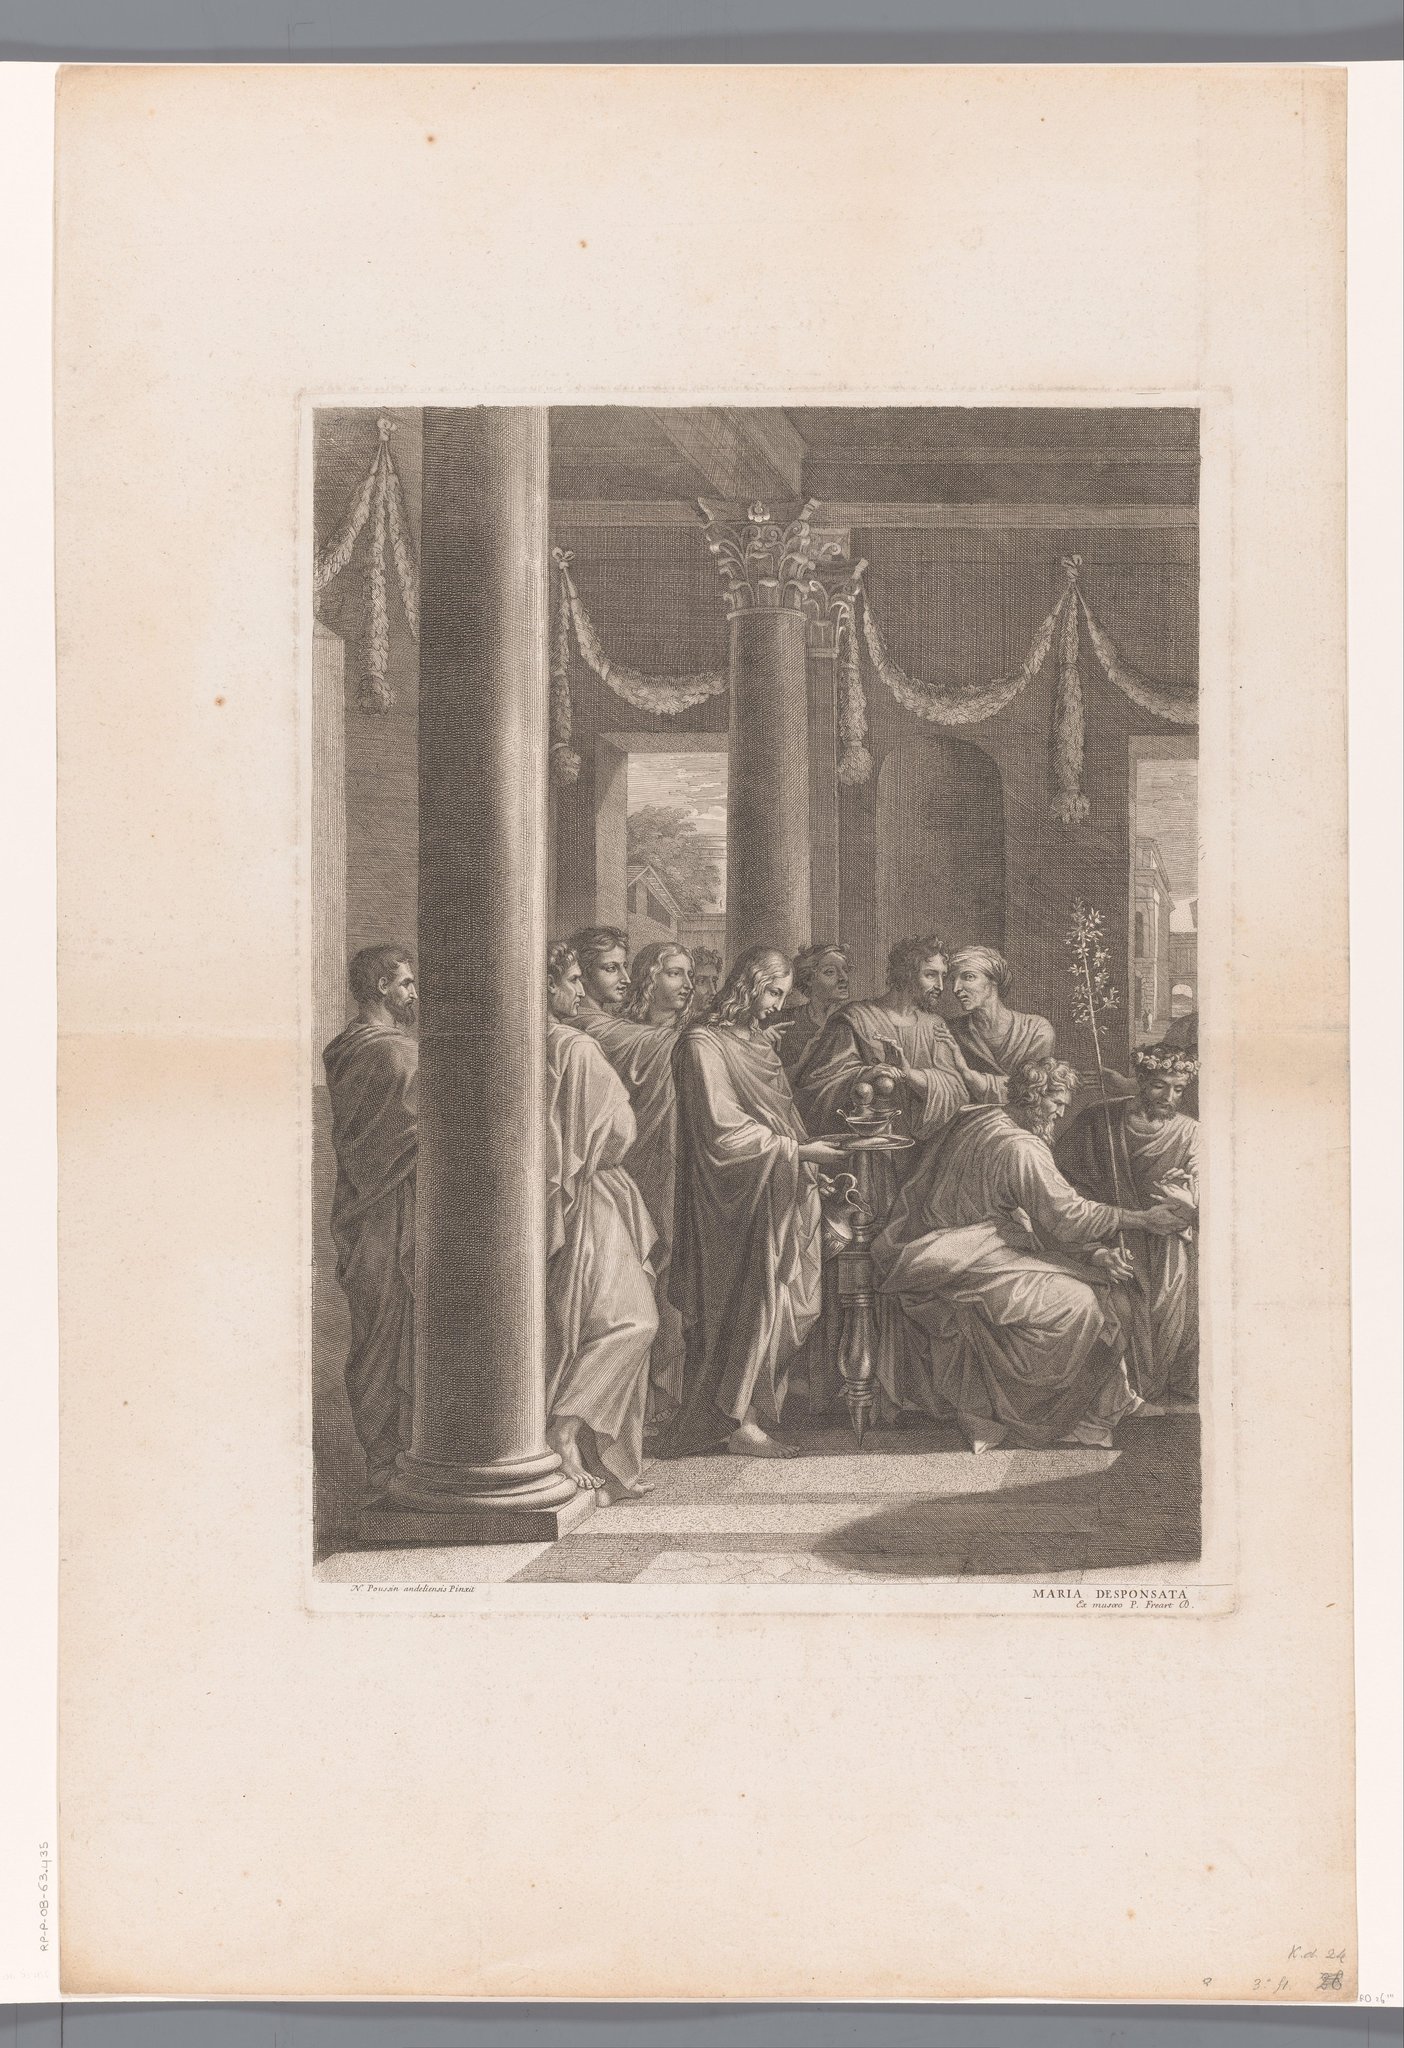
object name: print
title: Zeven sacramenten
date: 1680-1694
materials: paper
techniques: etching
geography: france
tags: marriage in church ~ the sixth of the seven sacraments, marriage of mary and joseph, 'sposalizio': they are married by the high priest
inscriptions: collector's mark: Lugt 240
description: Prent maakt deel uit van een ongenummerde serie van zeven prenten.